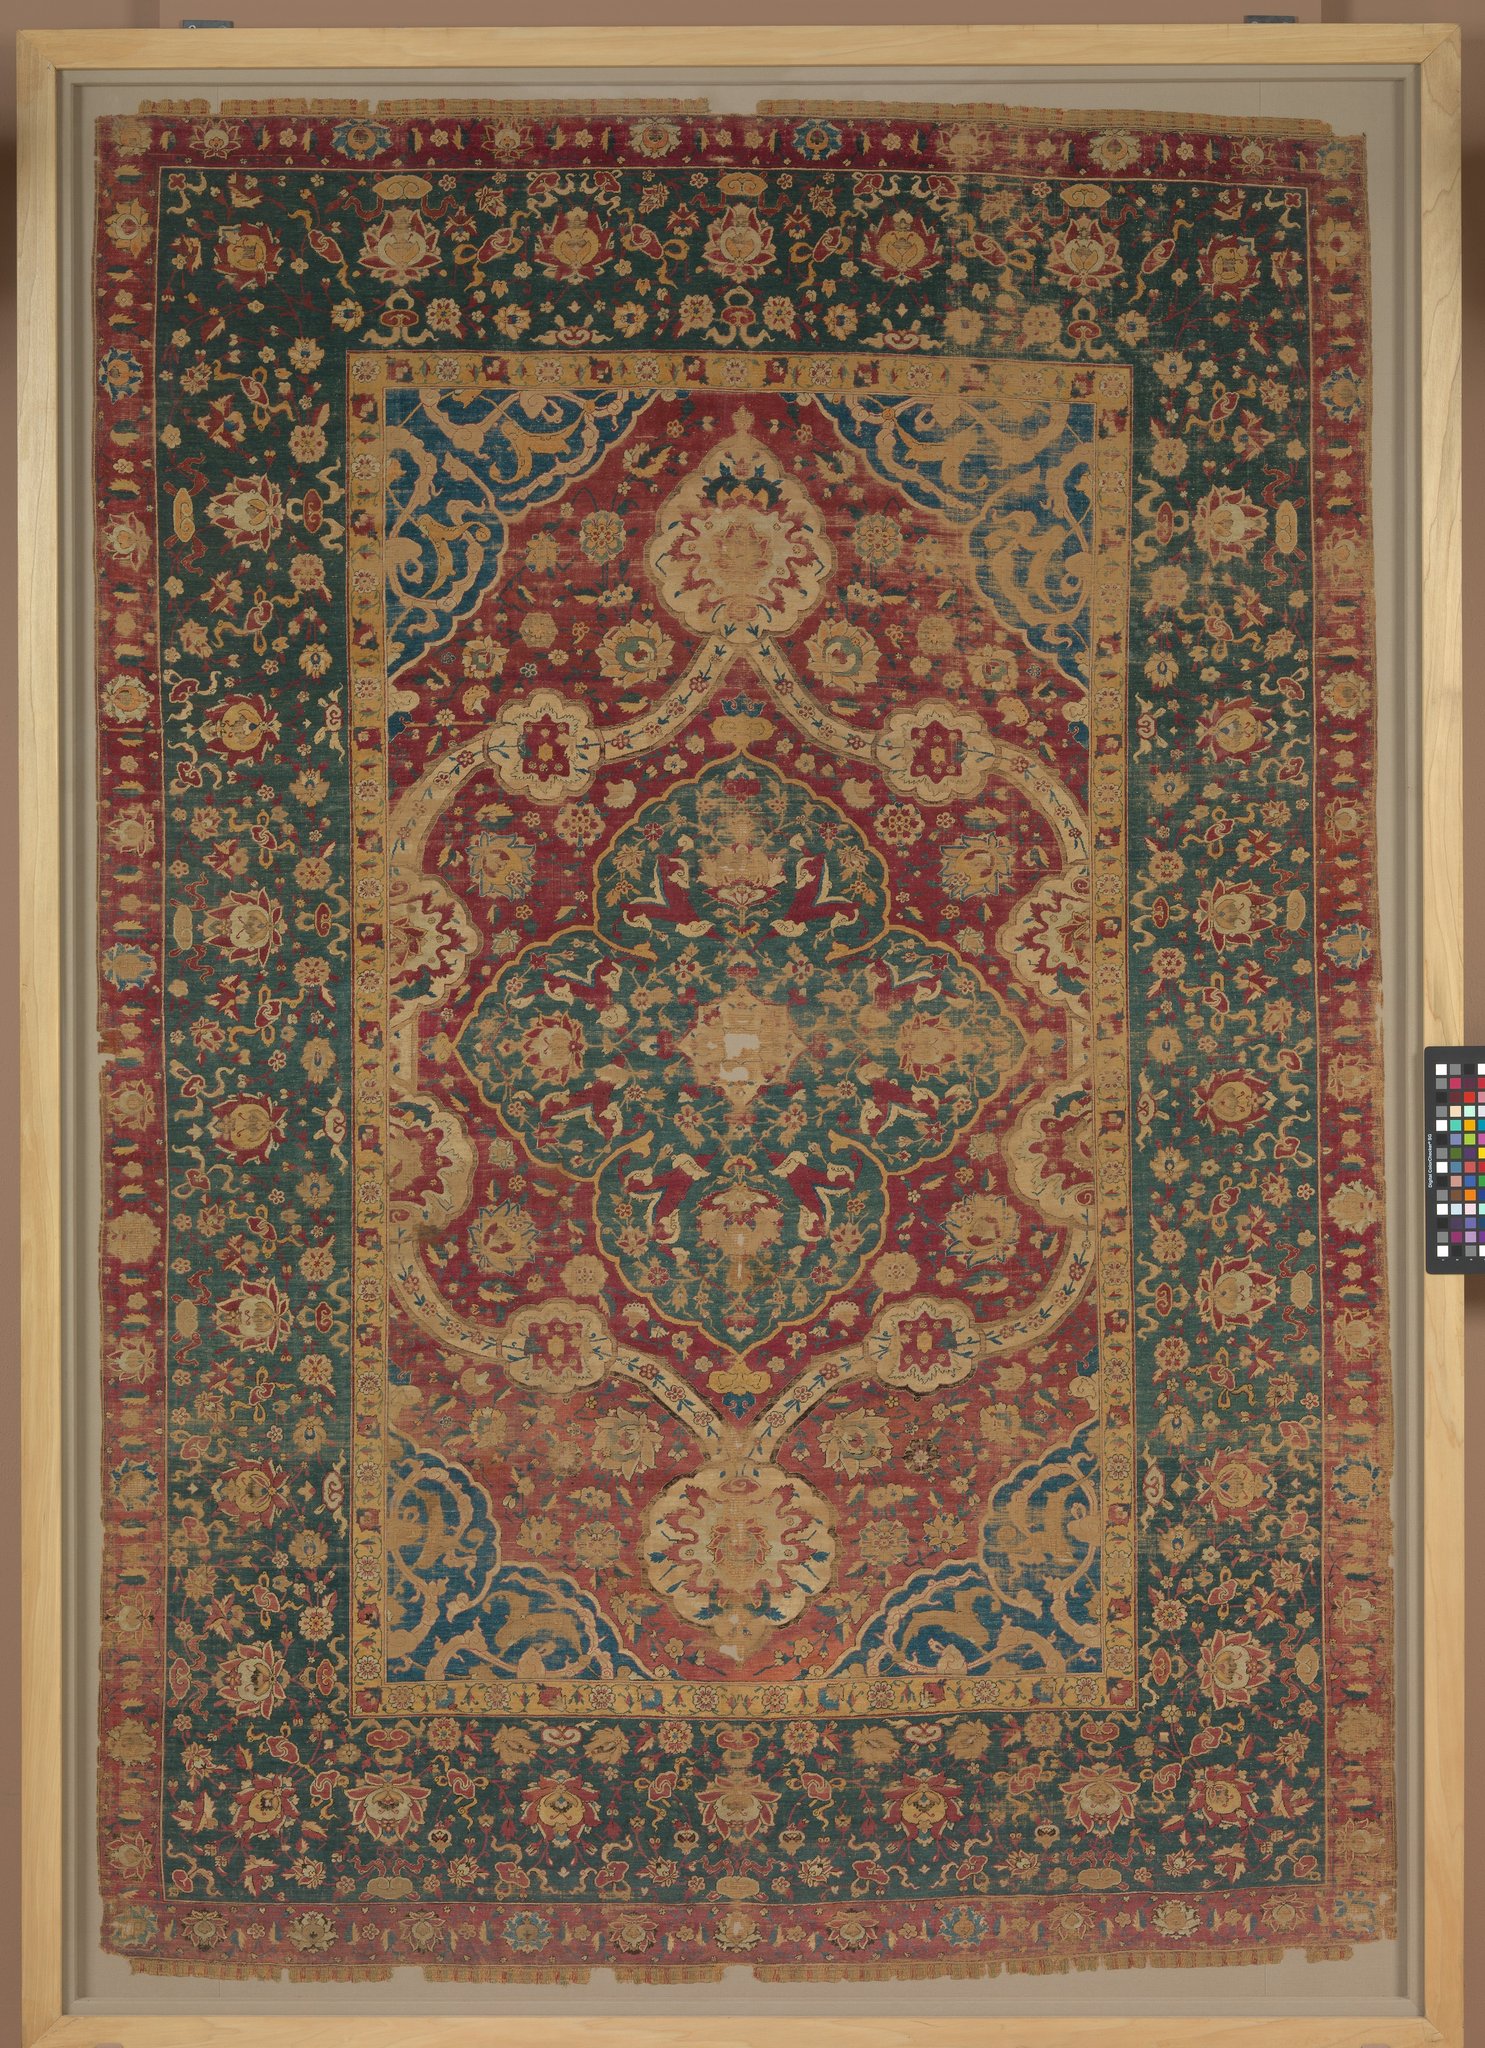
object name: carpet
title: Silk Kashan Carpet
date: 1501-1600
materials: silk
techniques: asymmetrically knotted pile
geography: iran